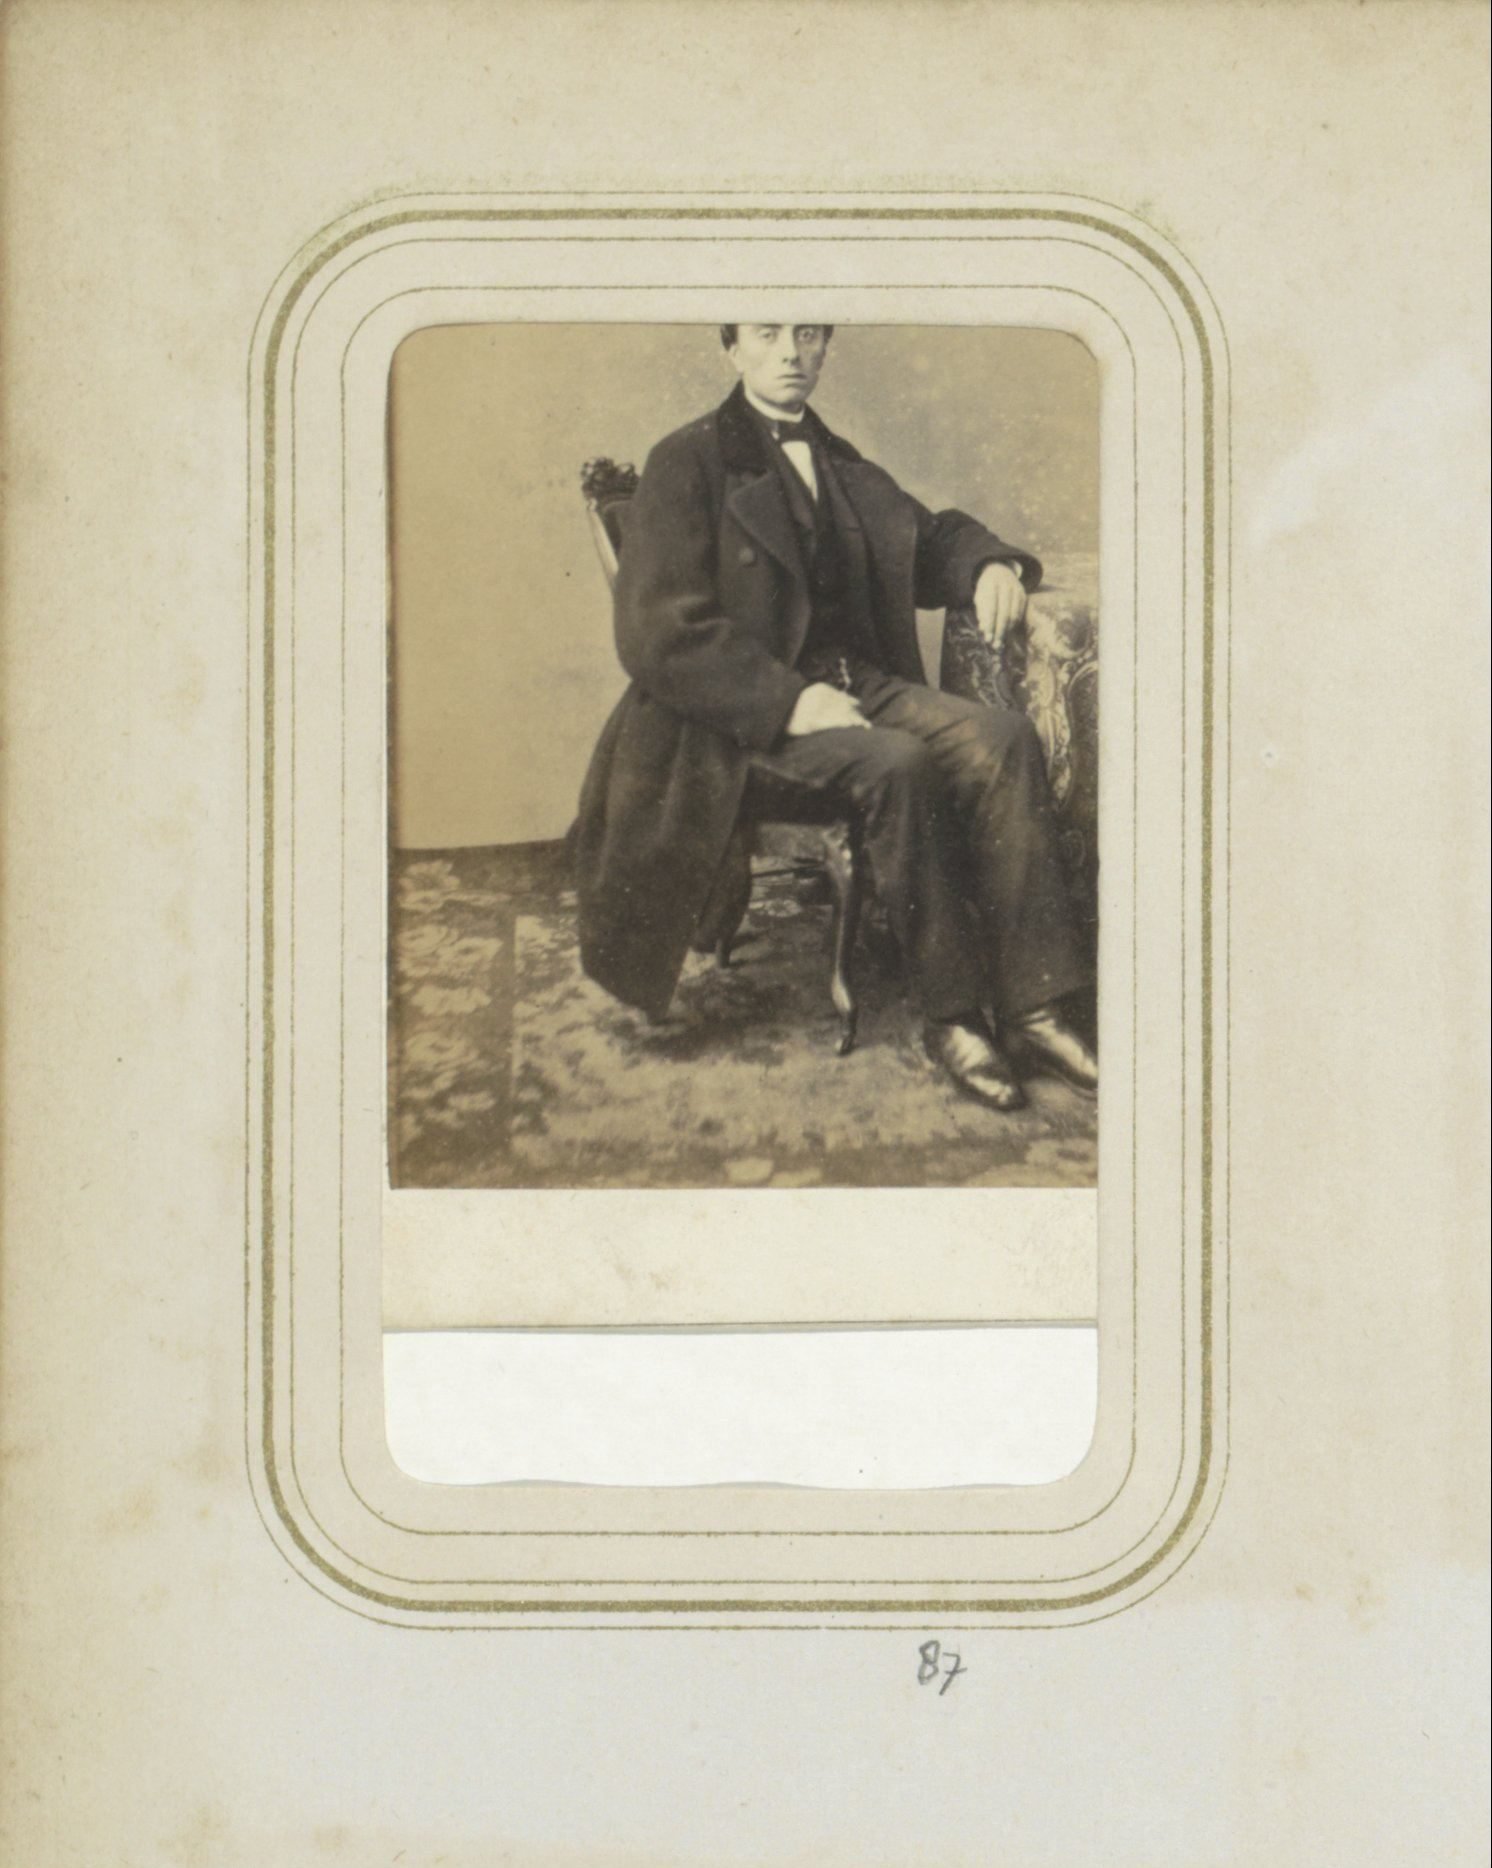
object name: carte de visite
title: Portret van een man met een lange jas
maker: alphonse plumier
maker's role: fotograaf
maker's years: 1819-1877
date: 1840-1877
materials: cardboard, photographic support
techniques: albumen print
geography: brussels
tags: studio requisites ~ photographer, trousers, breeches, historical persons, family, relationship, descent, shoes, sandals, hairdress, coat, cape, brussels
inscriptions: address: ‘St. Hubert 27 et rue d'Arenberg Bruxelles.’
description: Onderdeel van Familiealbum van H.W.F. Ligtenberg en L.M. Swart met 149 foto's en cartes-de-visite.